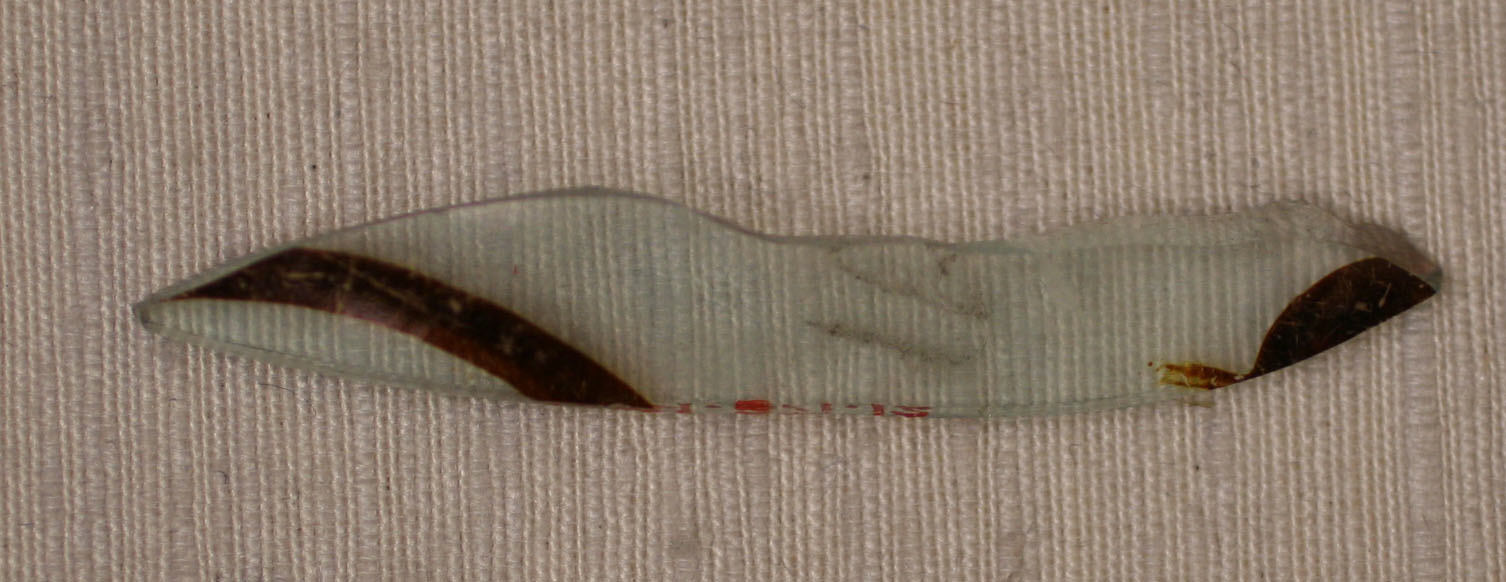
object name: fragment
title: Glass Fragment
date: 801-900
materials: glass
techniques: luster painting, stain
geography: egypt or iraq